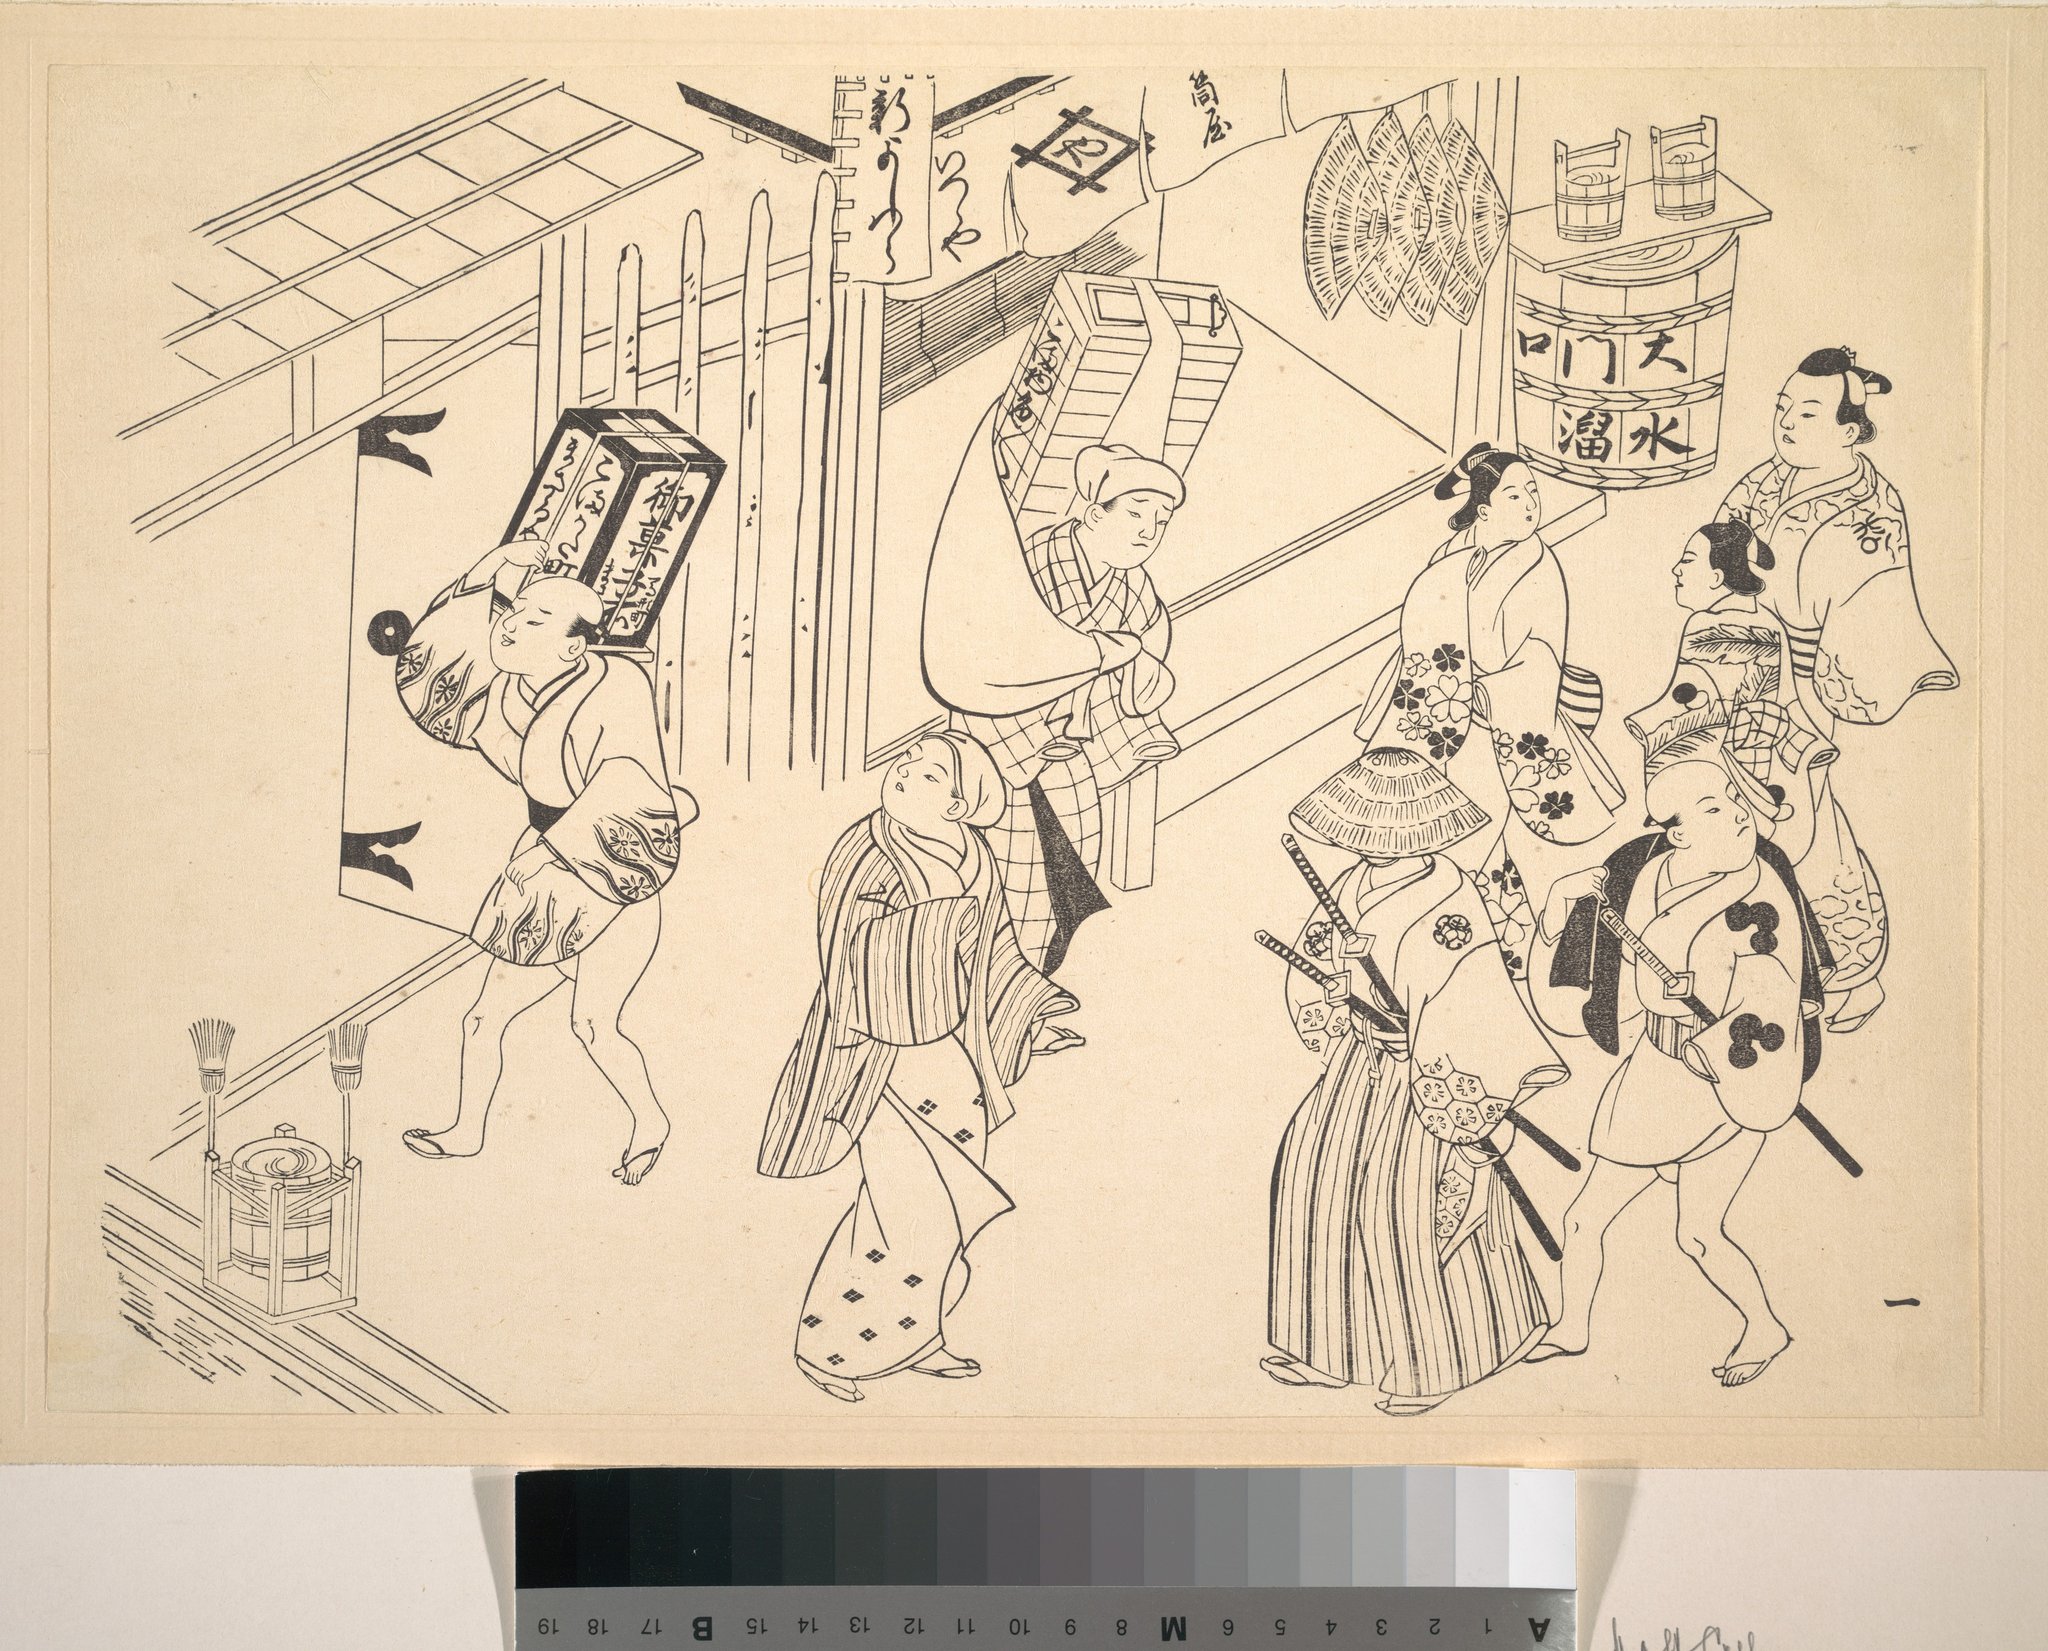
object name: print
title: A Number of People in the Street Going about Various Affairs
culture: japanese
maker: okumura masanobu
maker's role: artist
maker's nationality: japanese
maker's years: 1686-1764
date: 1868-1912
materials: ink, paper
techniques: woodblock print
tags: men,women,walking,street scene